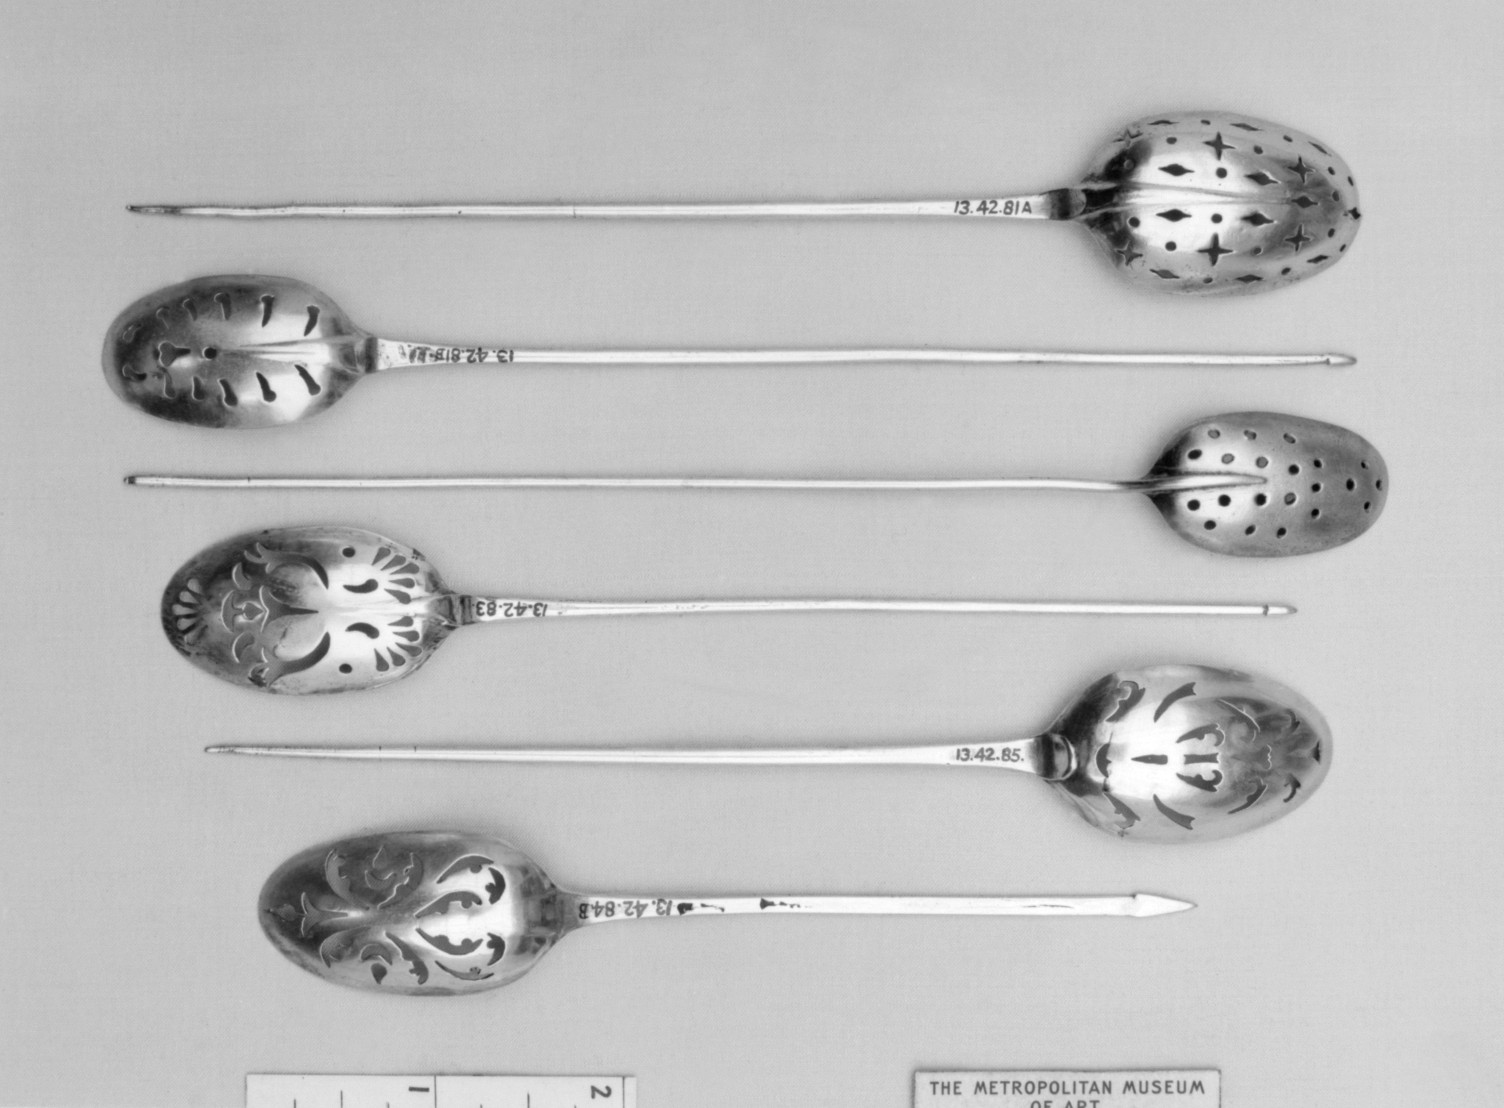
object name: strainer spoon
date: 1701-1800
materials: silver